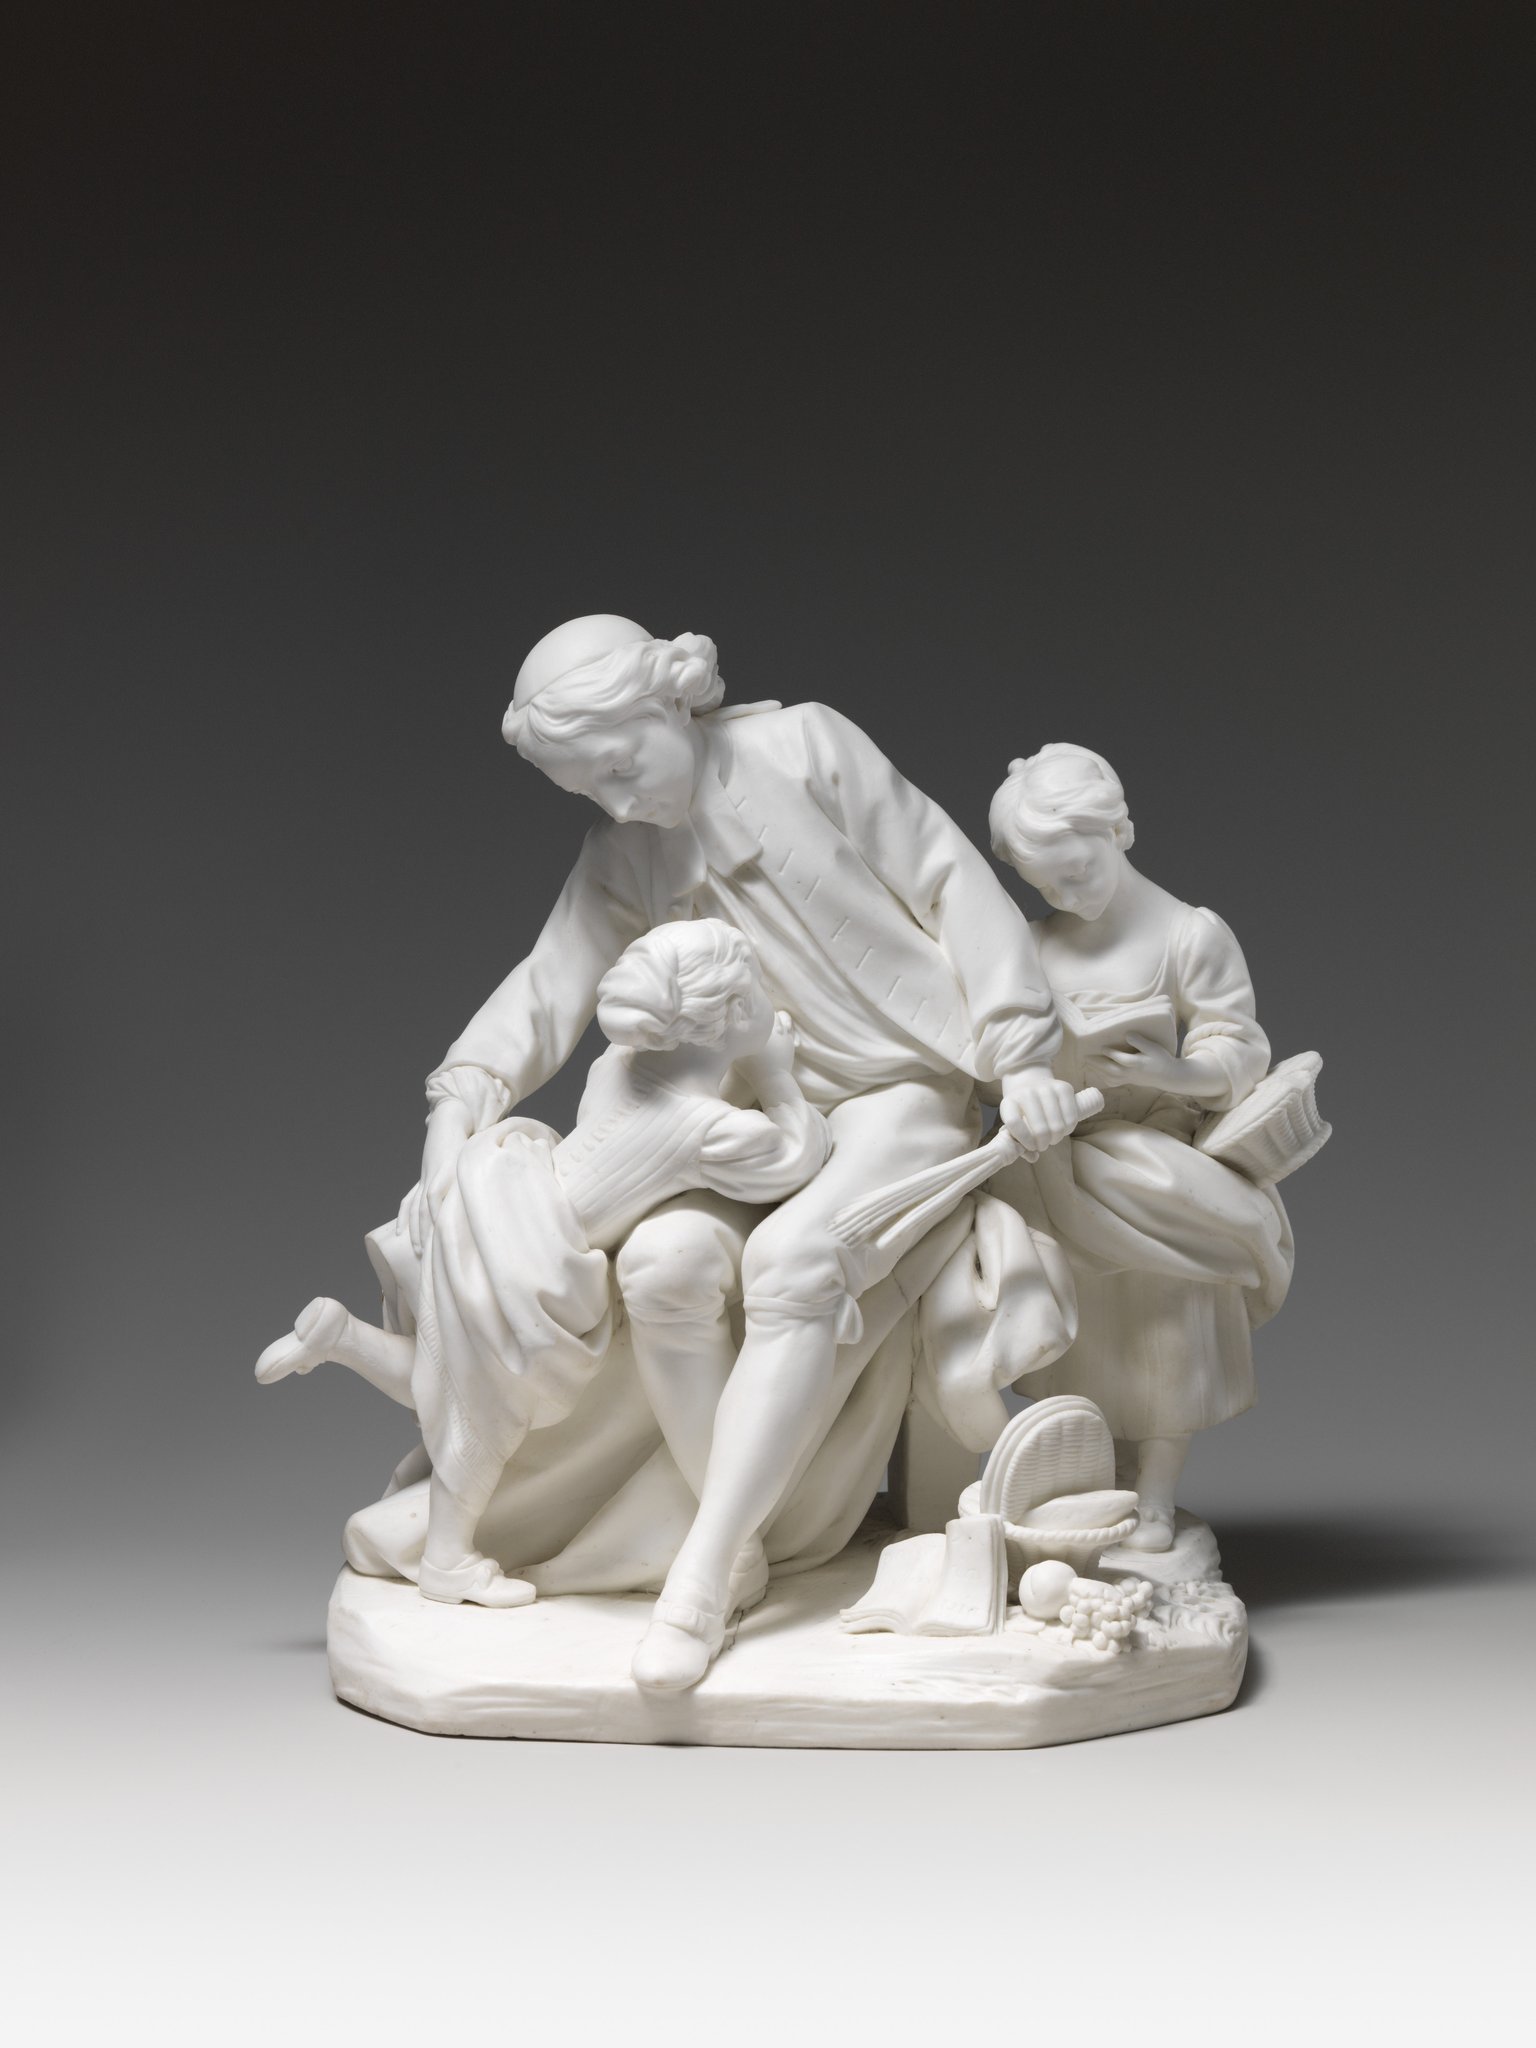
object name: group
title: The Schoolmaster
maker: sèvres manufactory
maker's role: manufactory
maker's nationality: french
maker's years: 1740-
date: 1762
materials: biscuit, paste, porcelain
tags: girls,men,reading